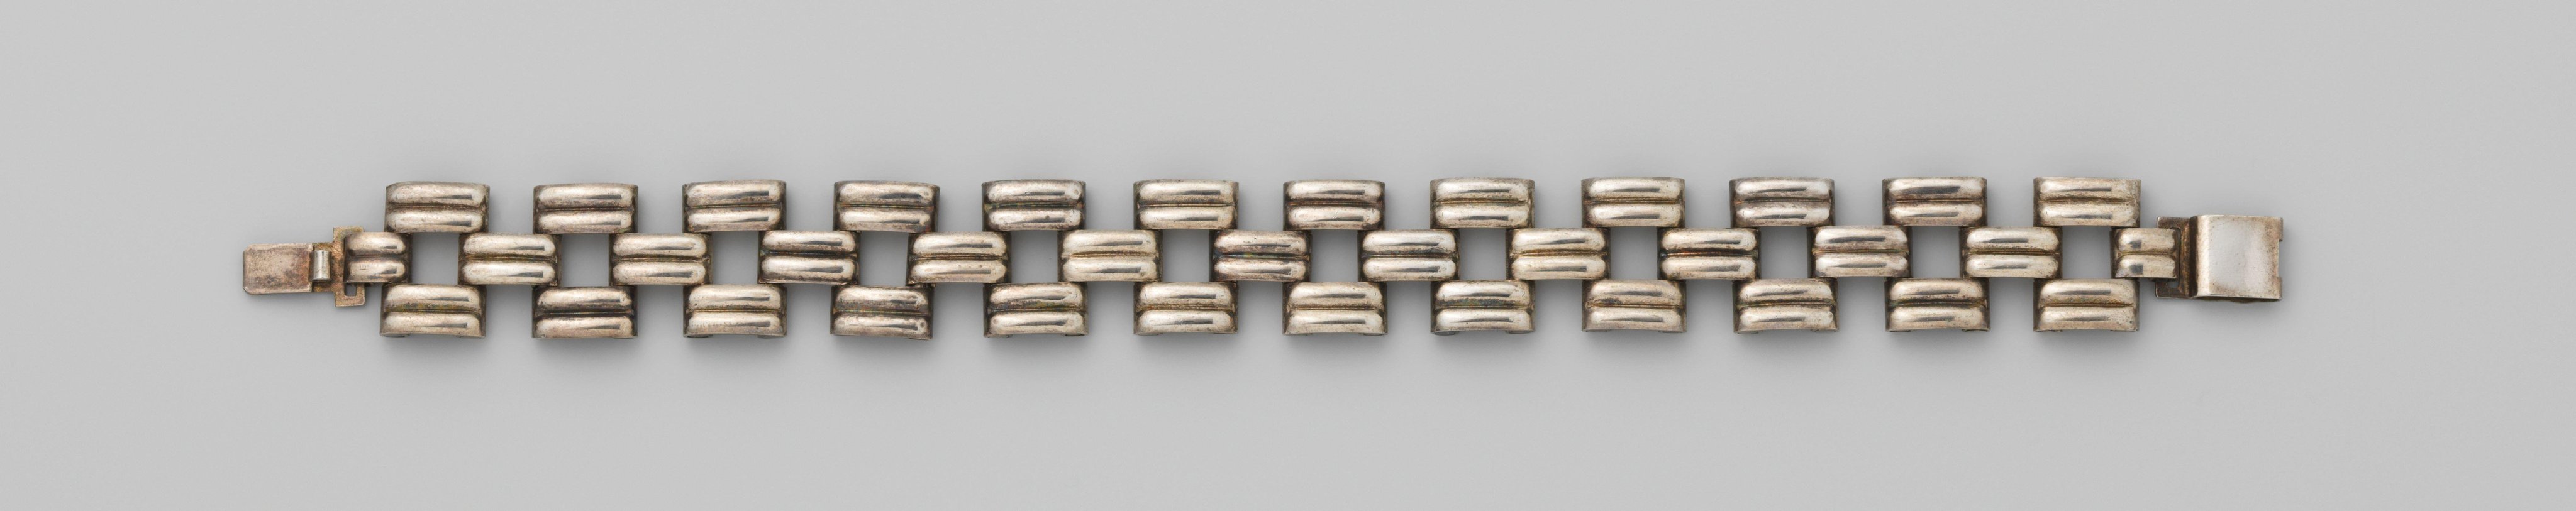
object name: bracelet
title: Armband van zilver, smalle versie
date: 1945-1950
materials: silver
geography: amsterdam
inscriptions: maker's mark: ‘9HJ’, alloy mark: ‘oud zwaard’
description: De armband is een voorbeeld van een zogenaamde tankarmband, refererend aan de rupsbanden van tanks die in de Tweede Wereldoorlog werden gebruikt.